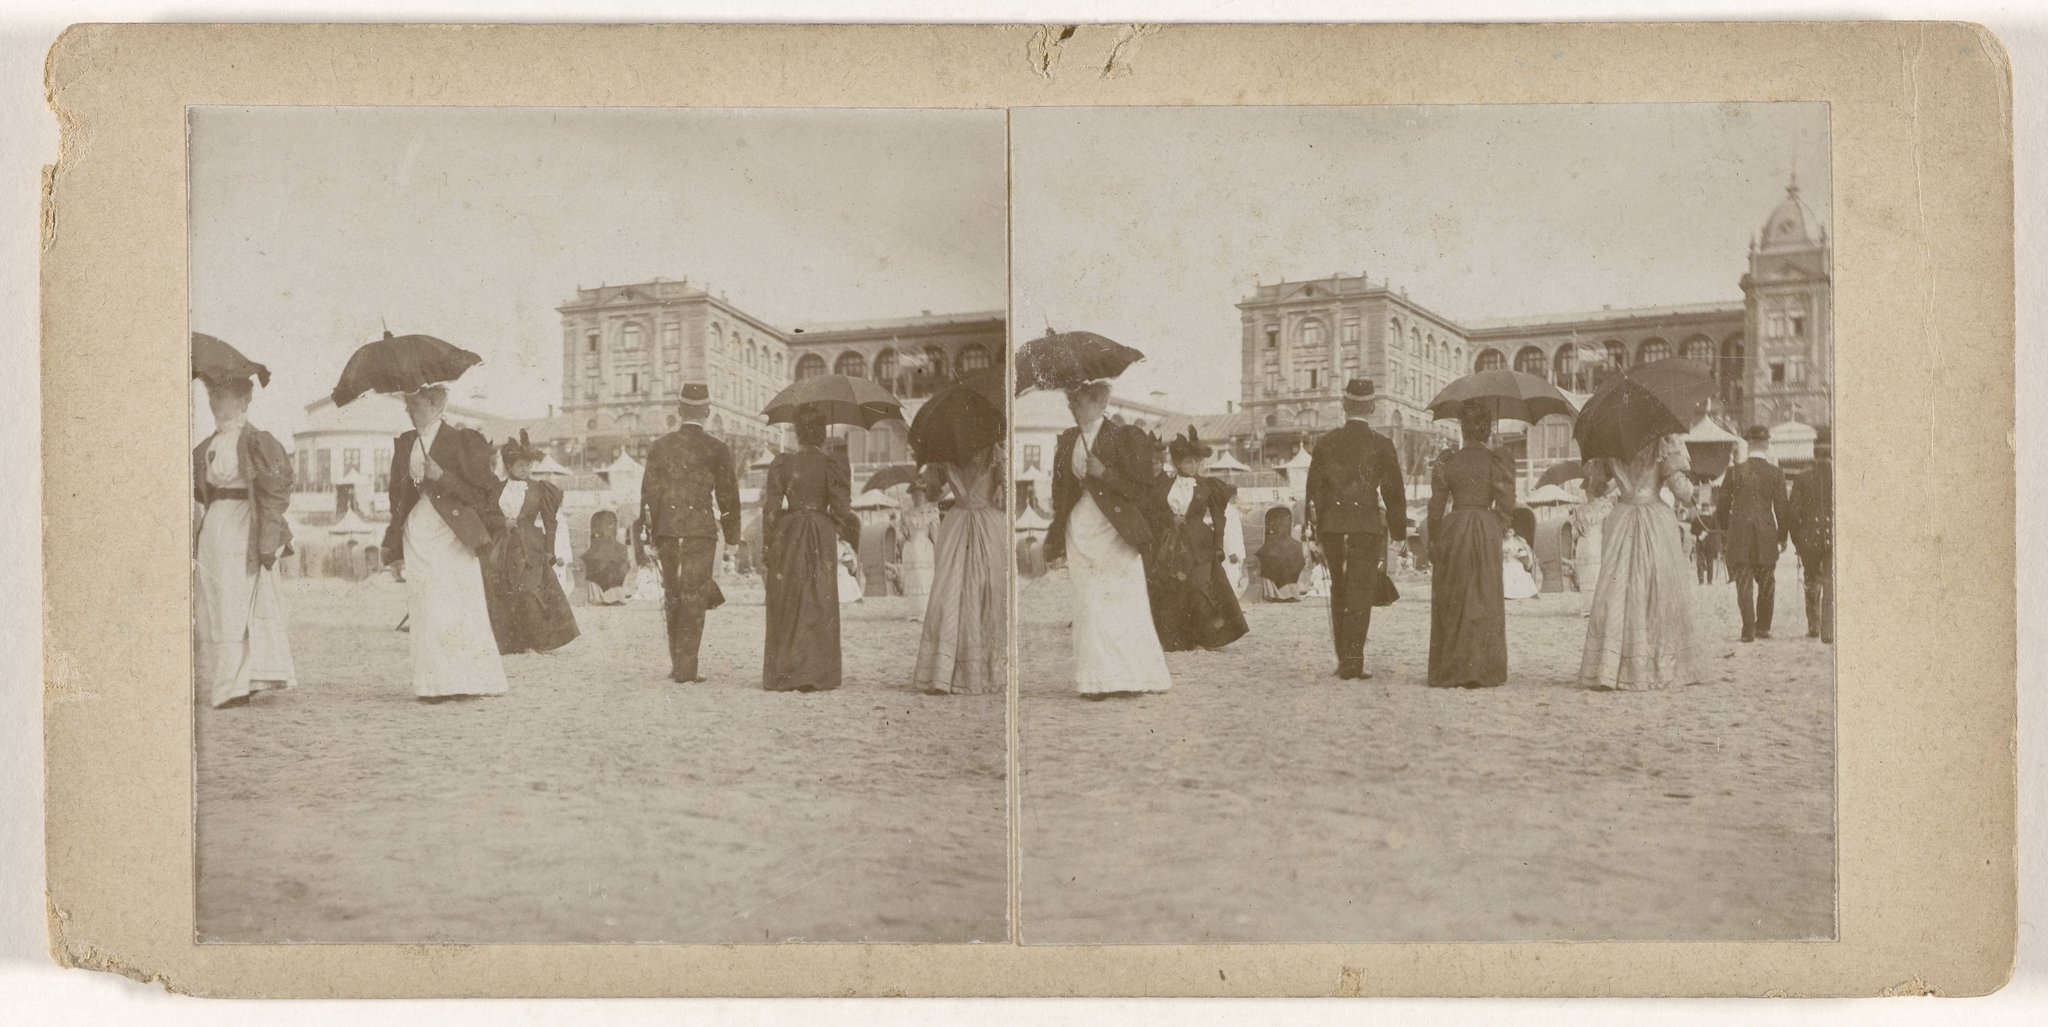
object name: stereograph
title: Mensen flaneren over het strand van Scheveningen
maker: Anonymous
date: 1894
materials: paper, cardboard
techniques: gelatin silver print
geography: scheveningen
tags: beach (as place of recreation), strolling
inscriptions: date: ‘Seizoen 1894’